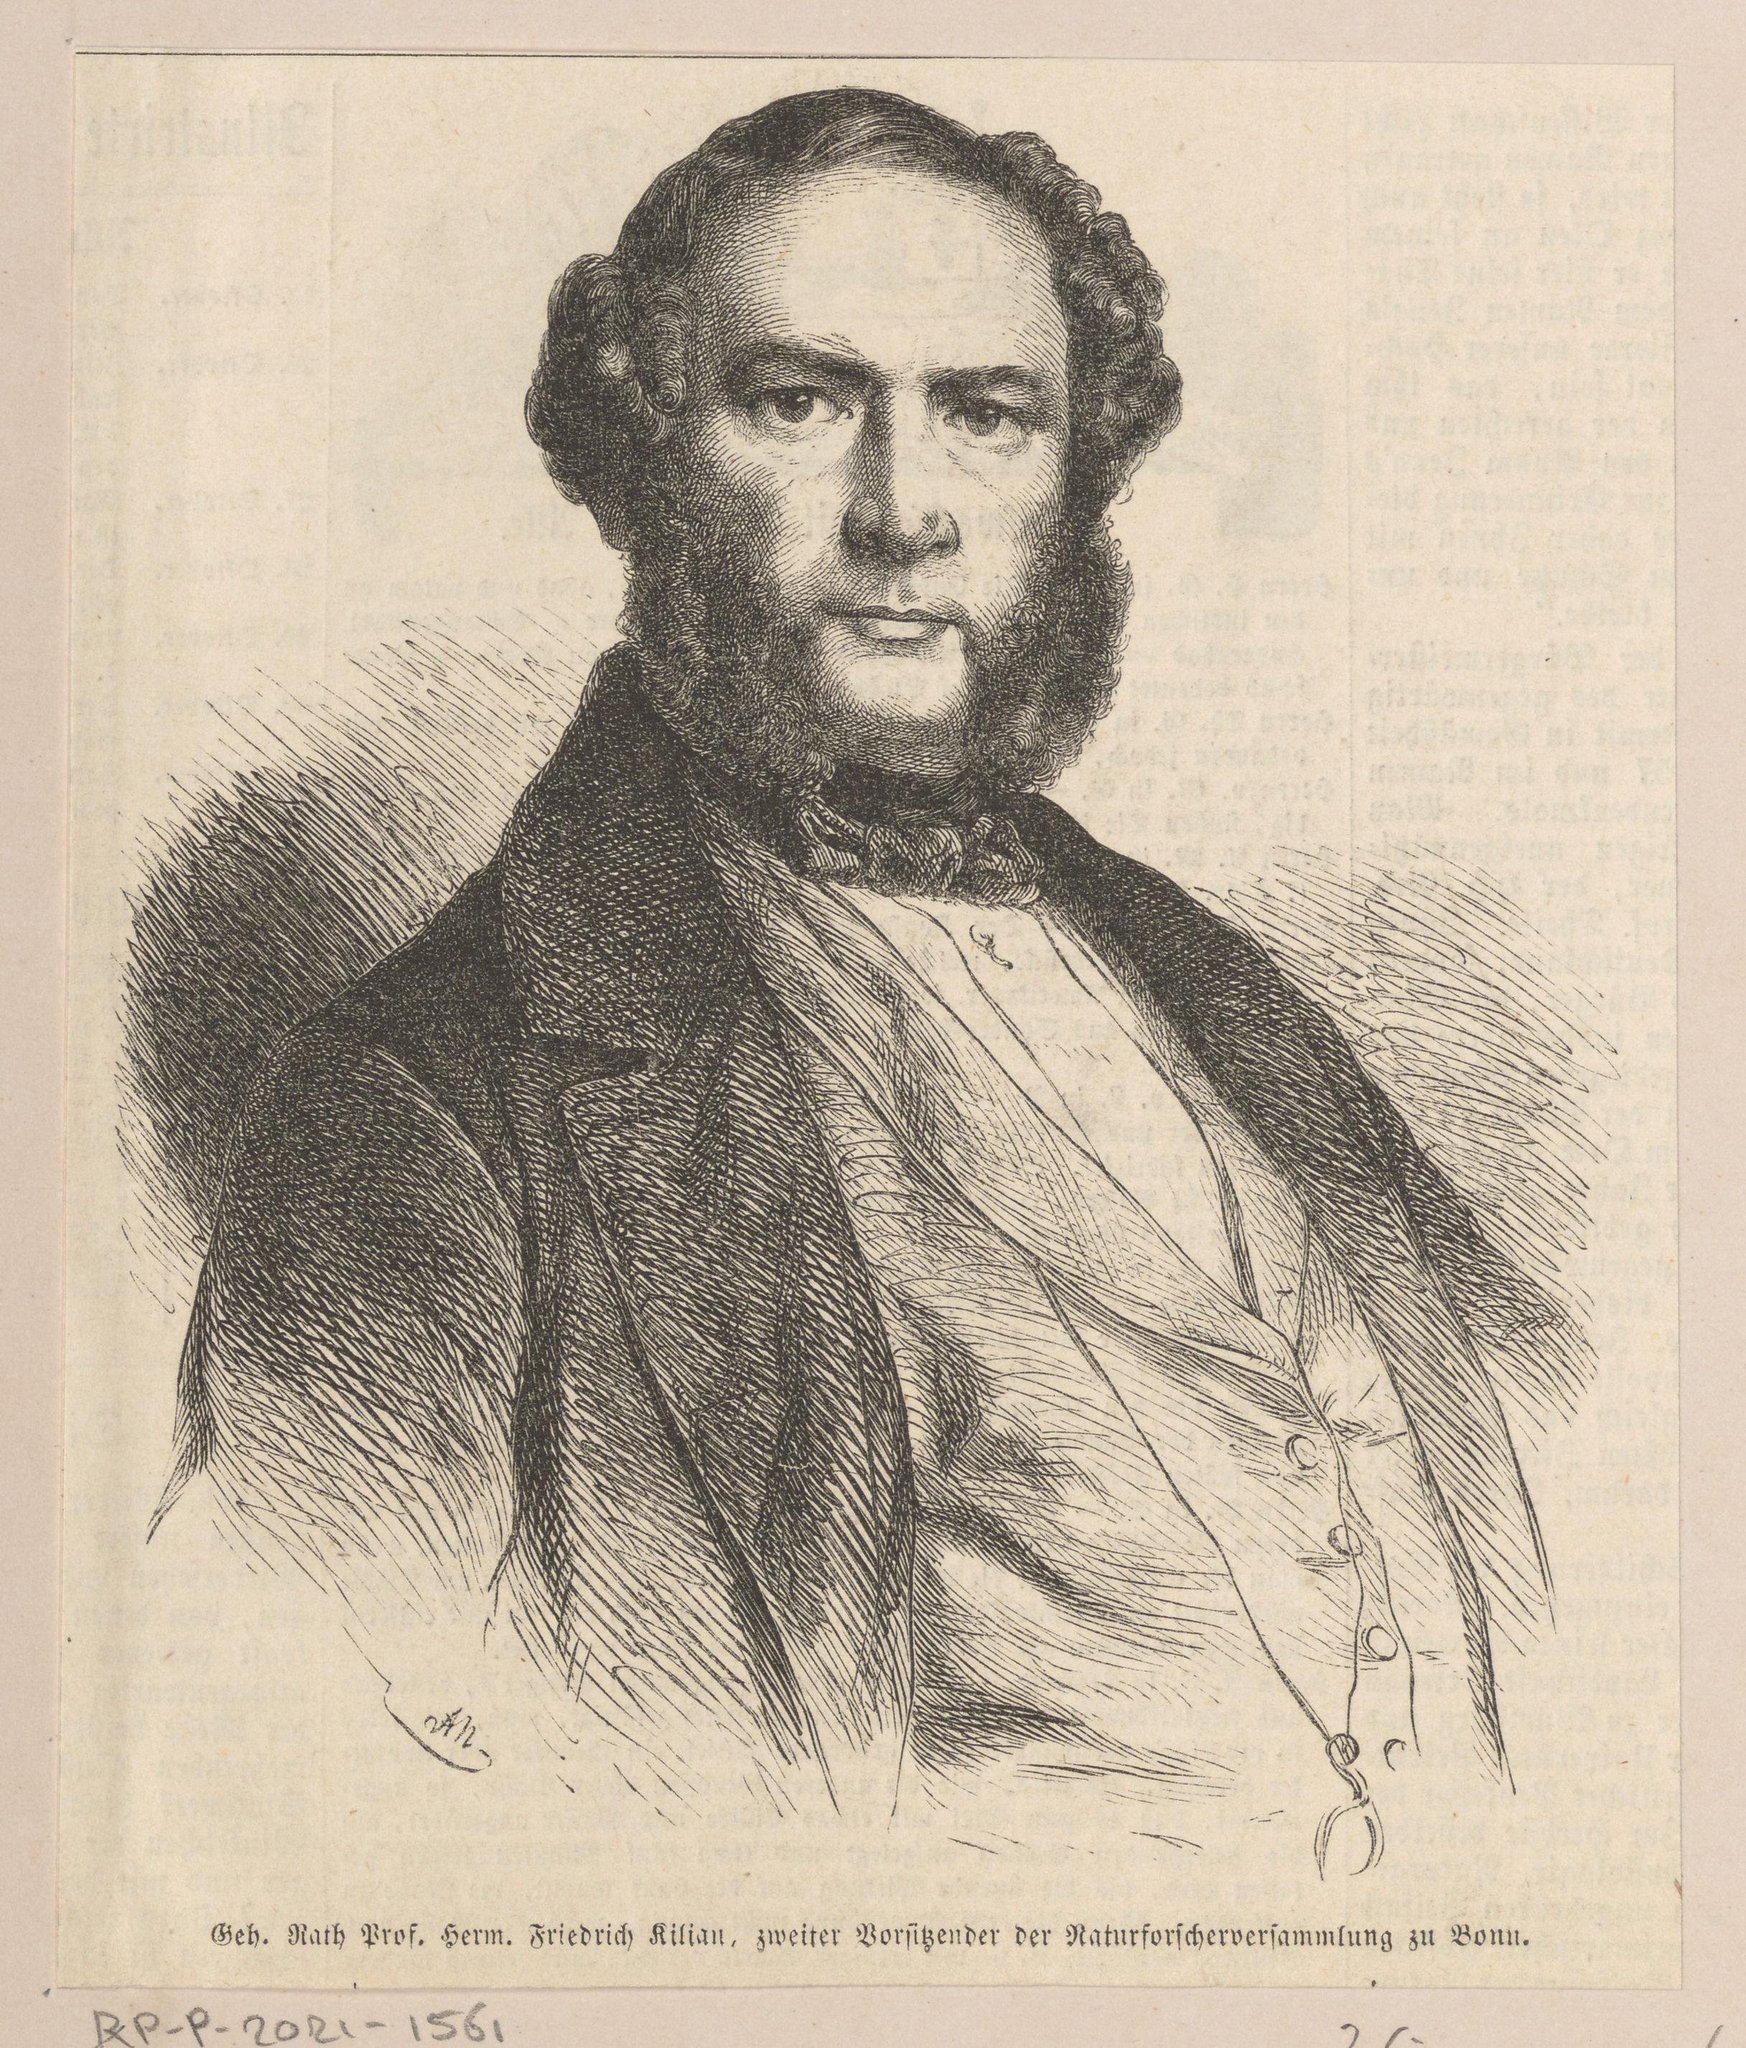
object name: print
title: Portret van Hermann Kilian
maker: Anonymous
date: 1830-1899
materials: paper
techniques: letterpress printing, engraving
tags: hermann kilian, historical persons